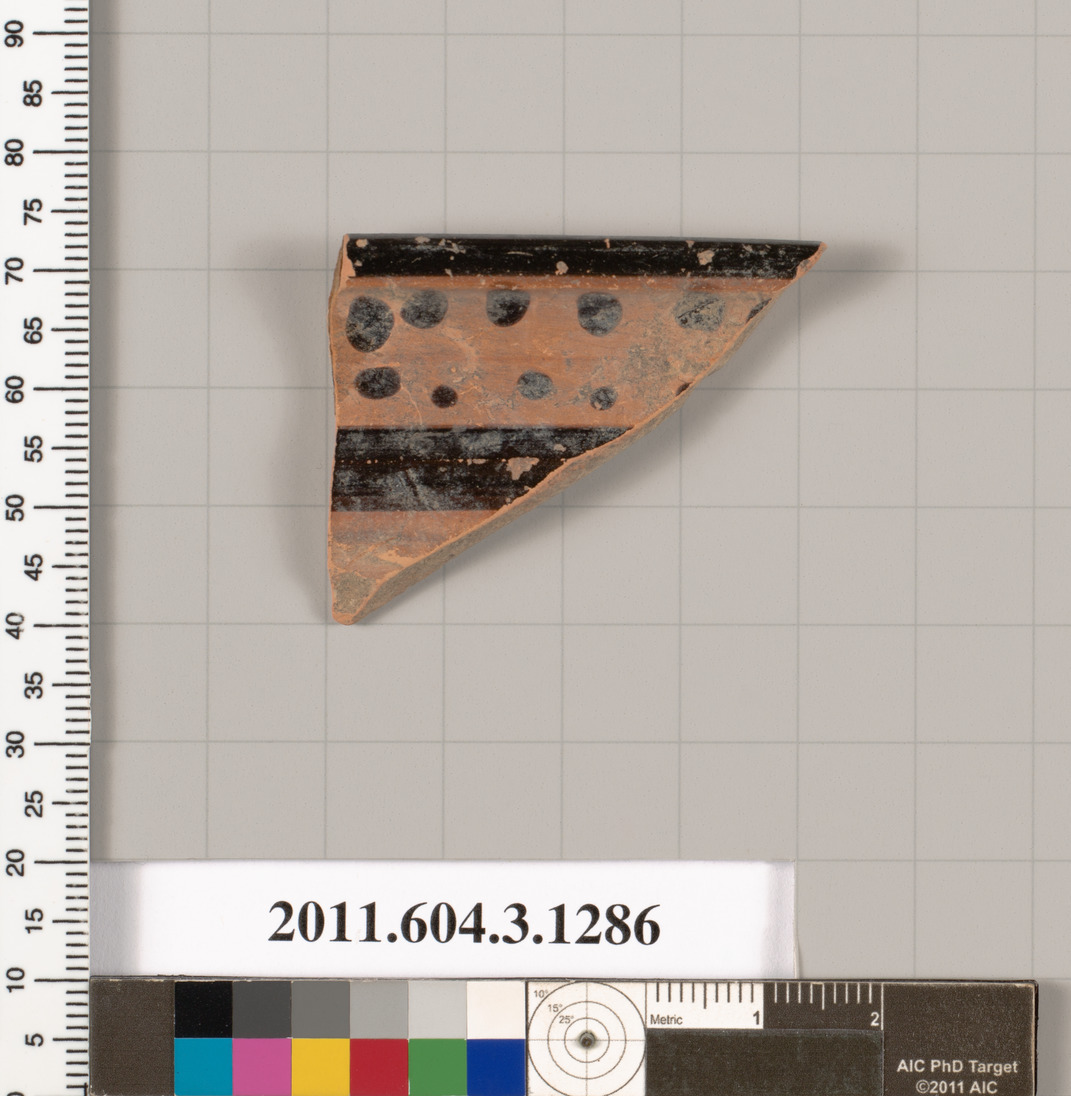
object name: skyphos fragment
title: Terracotta rim fragment of a skyphos (deep drinking cup)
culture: greek, attic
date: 500 BCE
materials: terracotta